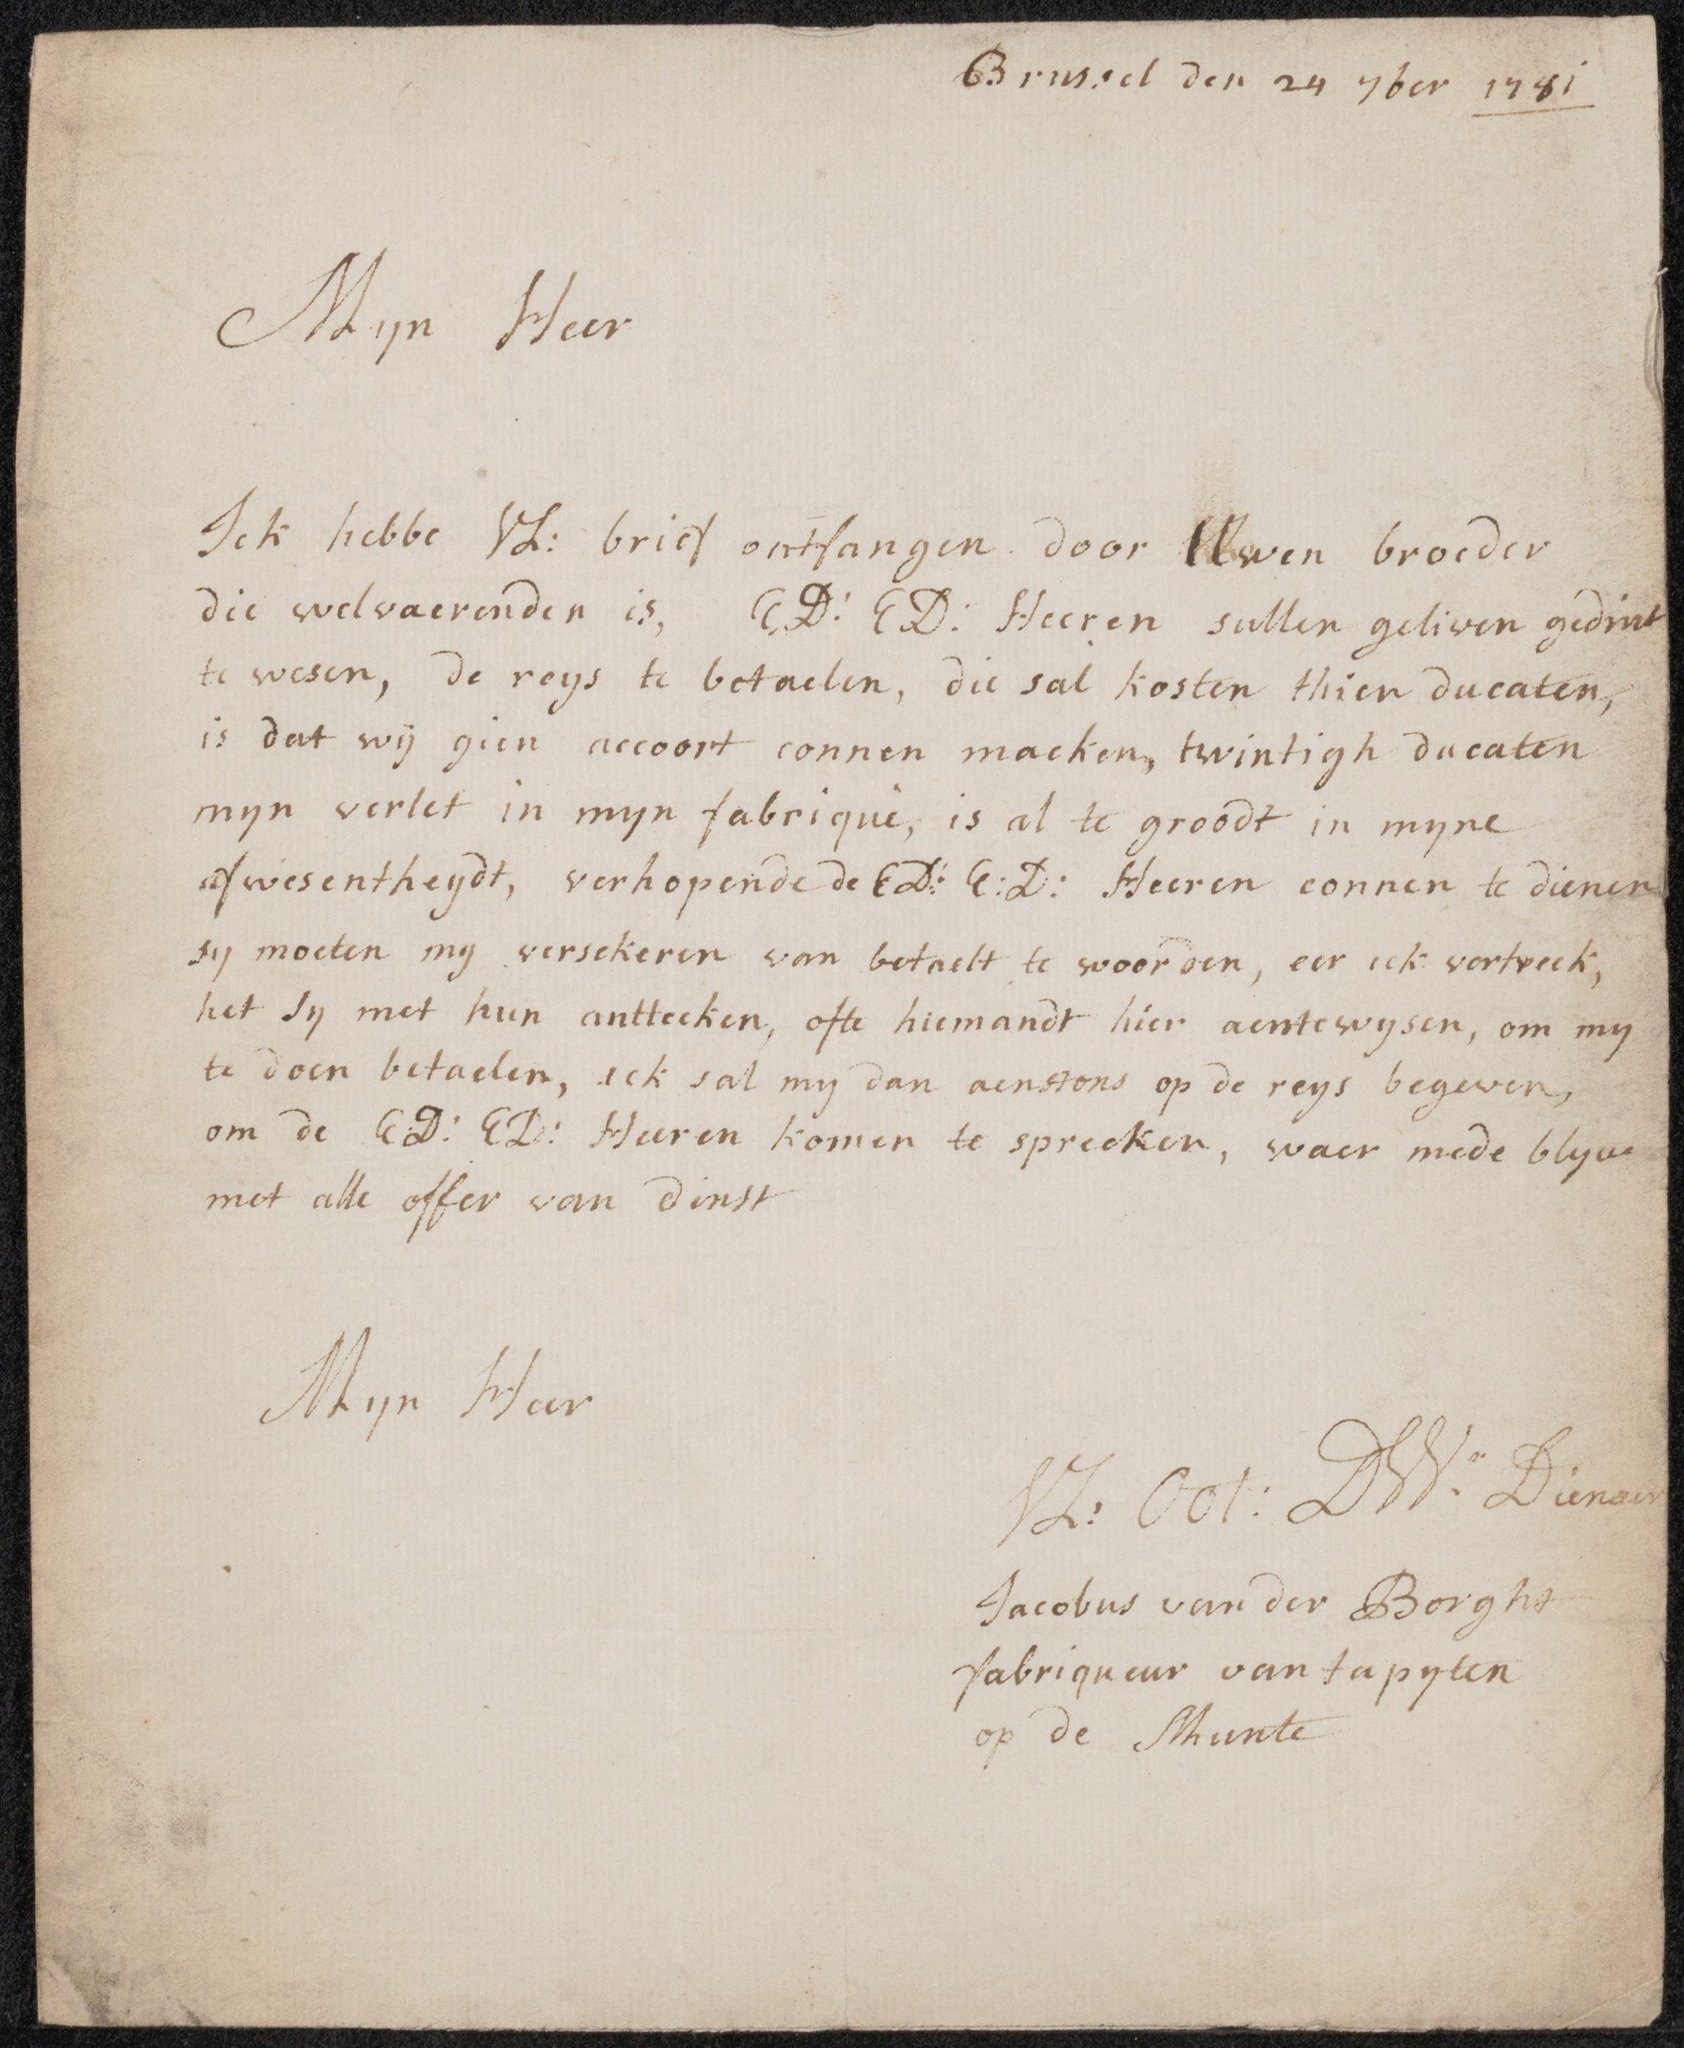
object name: letter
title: Brief aan Guilielmus Clabbeeck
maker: jacob van der borcht (ii)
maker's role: tapijtwever, wever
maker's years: -1794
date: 1781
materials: ink, paper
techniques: pen, writing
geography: brussels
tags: applied arts, arts and crafts; industrial design, money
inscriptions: collector's mark: Lugt 2228, watermark, seal